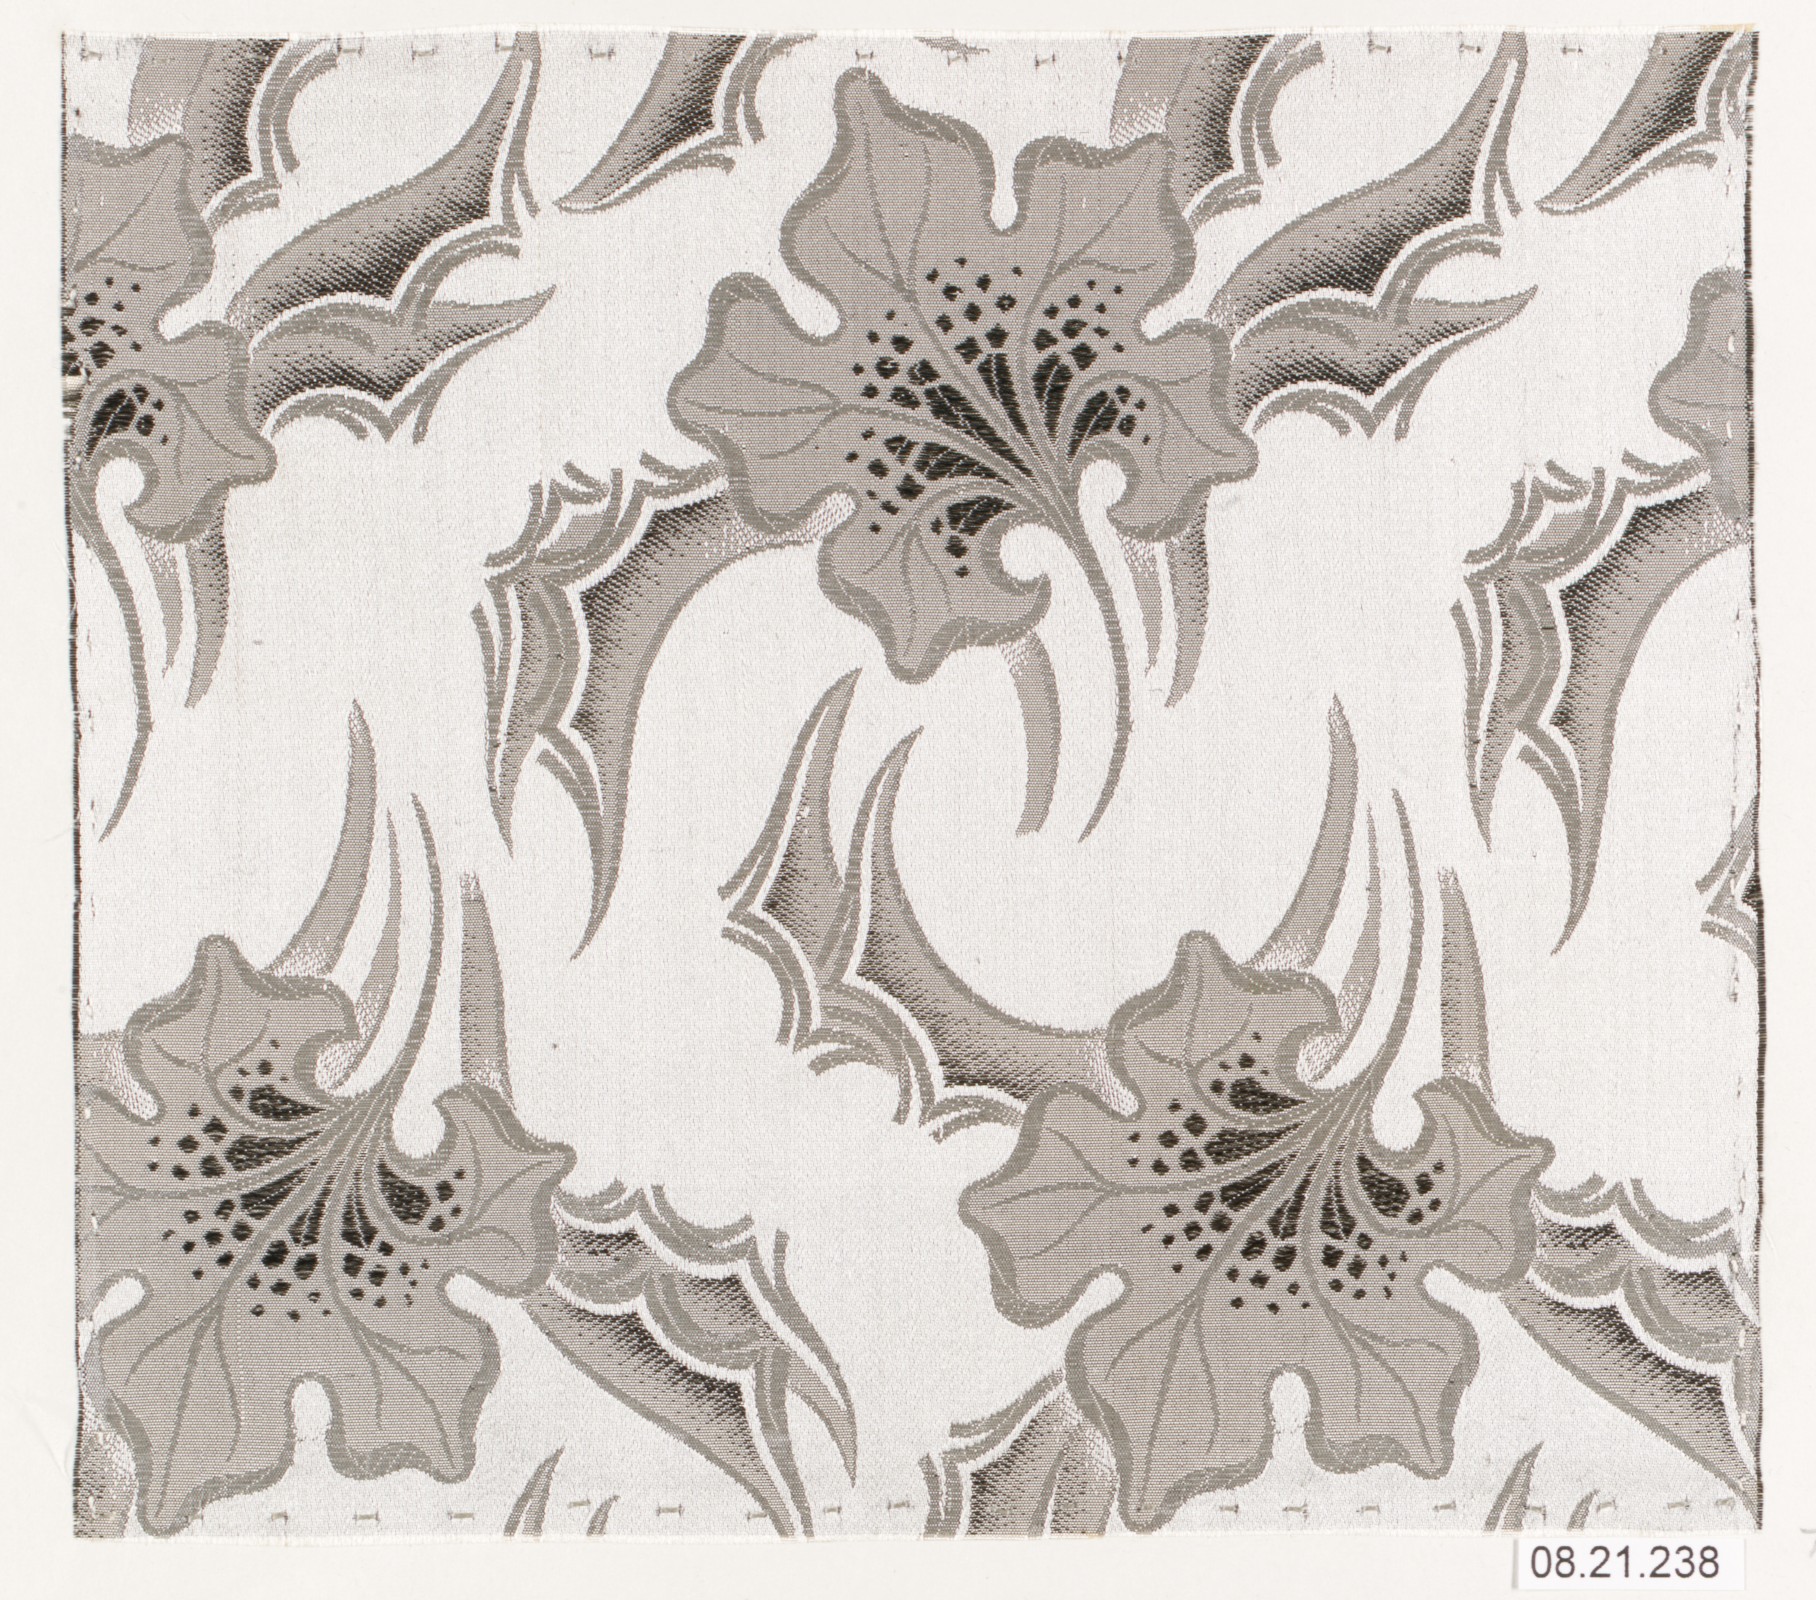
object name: textile sample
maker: Anonymous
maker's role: designer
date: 1900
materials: silk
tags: flowers